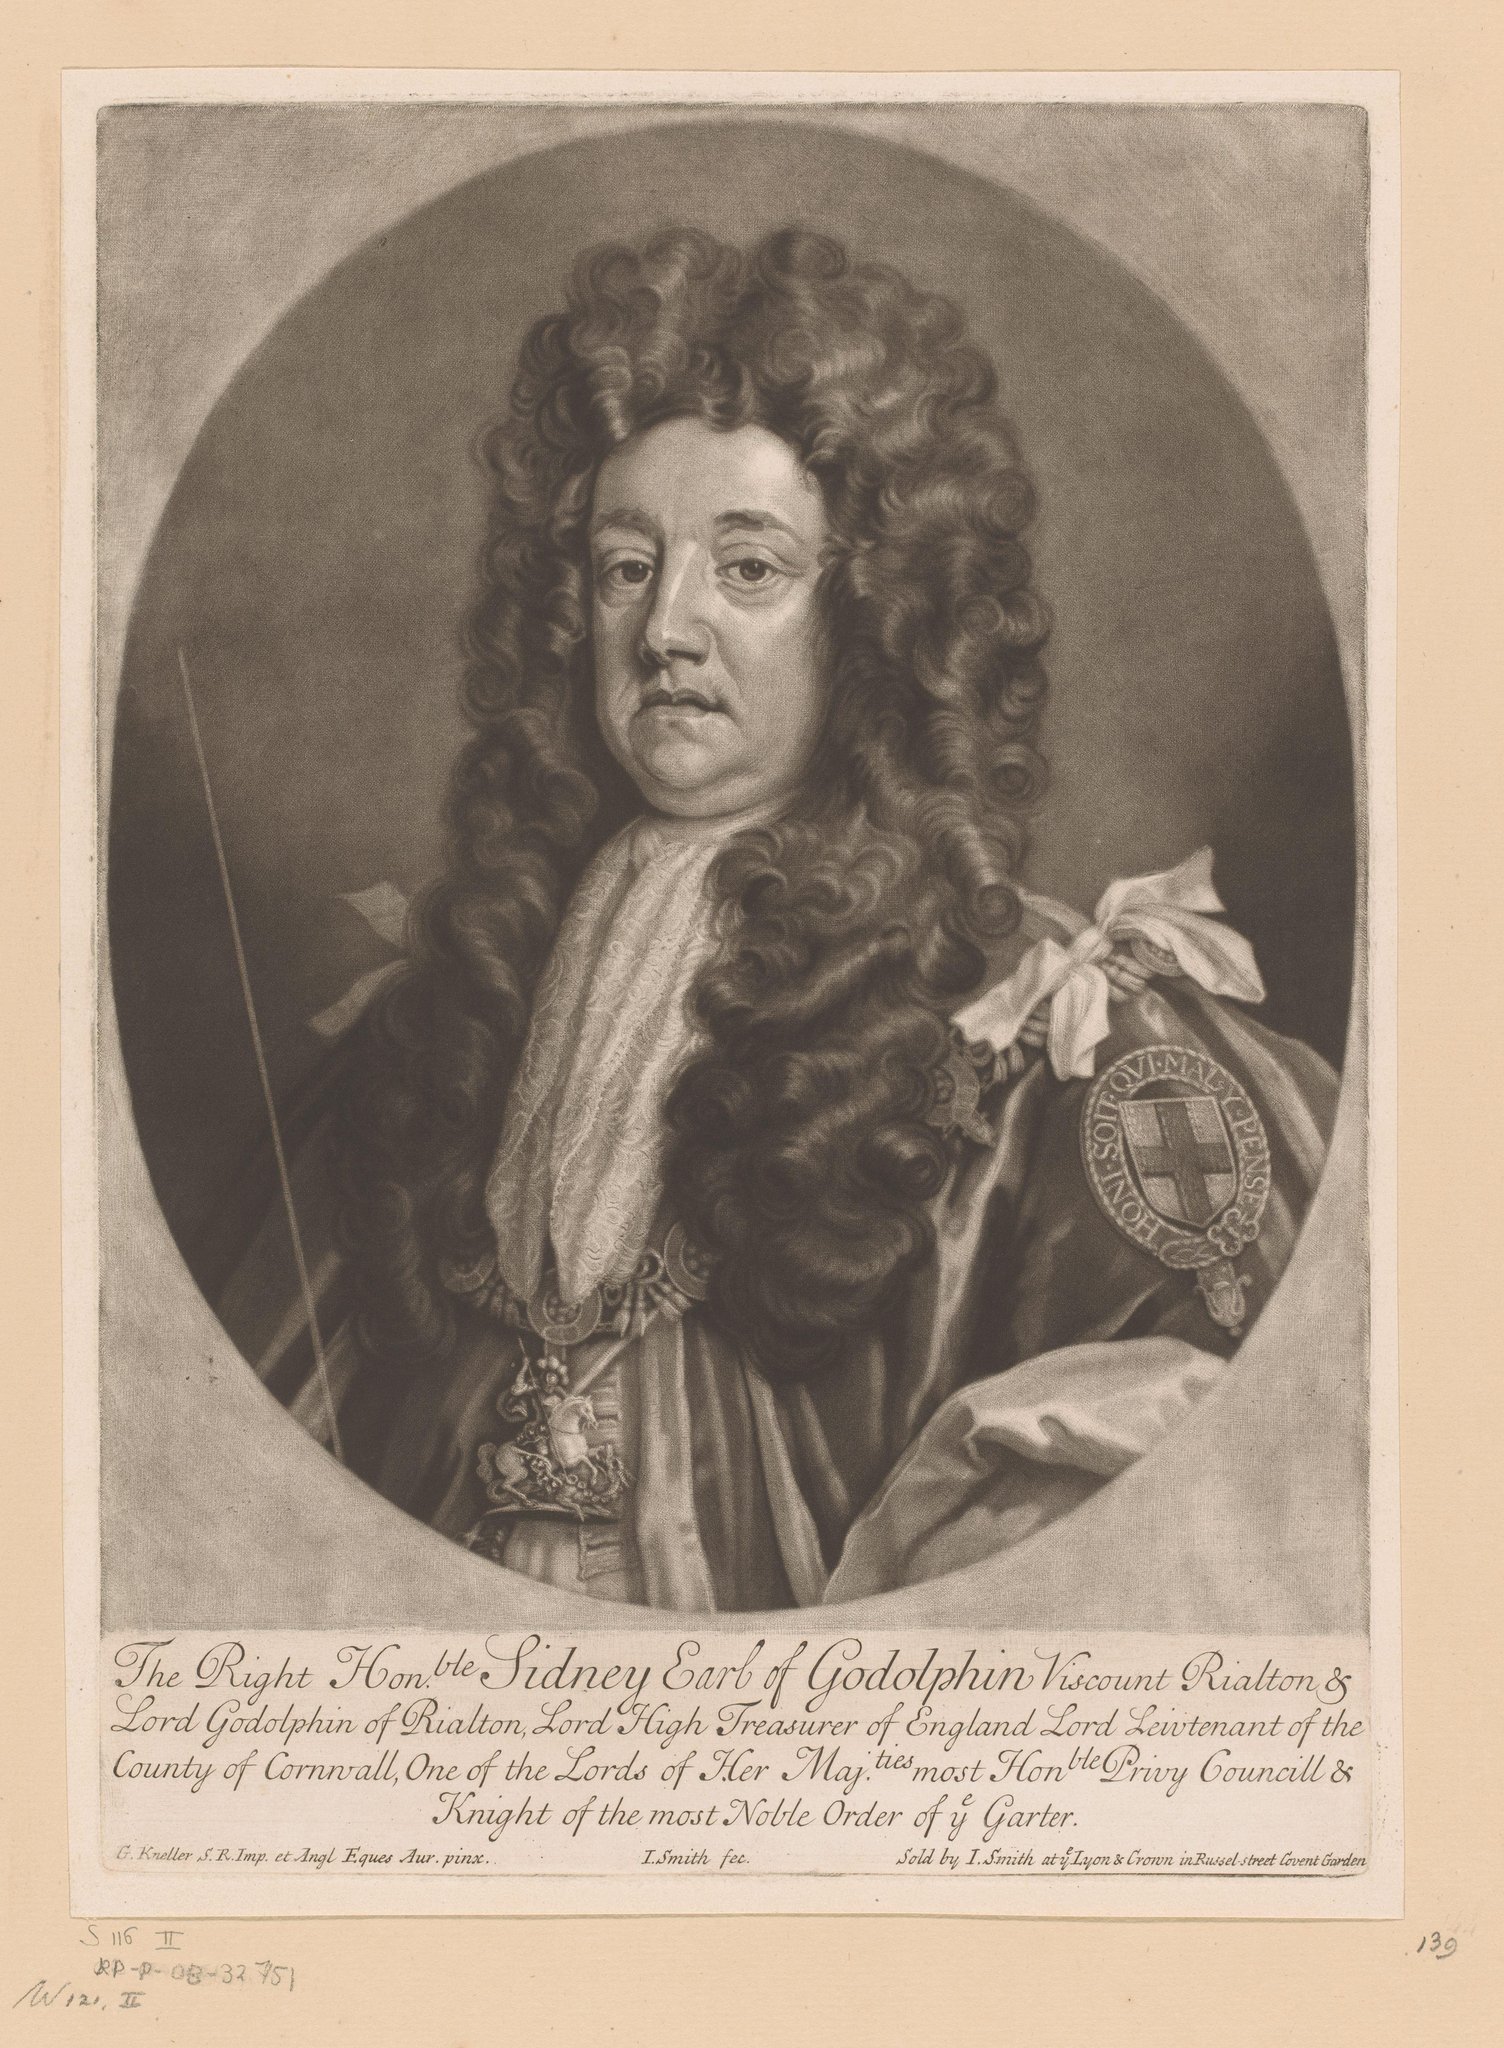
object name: print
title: Portret van Sidney Godolphin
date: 1662-1742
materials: paper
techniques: mezzotint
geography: london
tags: historical persons, politician, e.g. party leader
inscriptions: collector's mark: Lugt 240